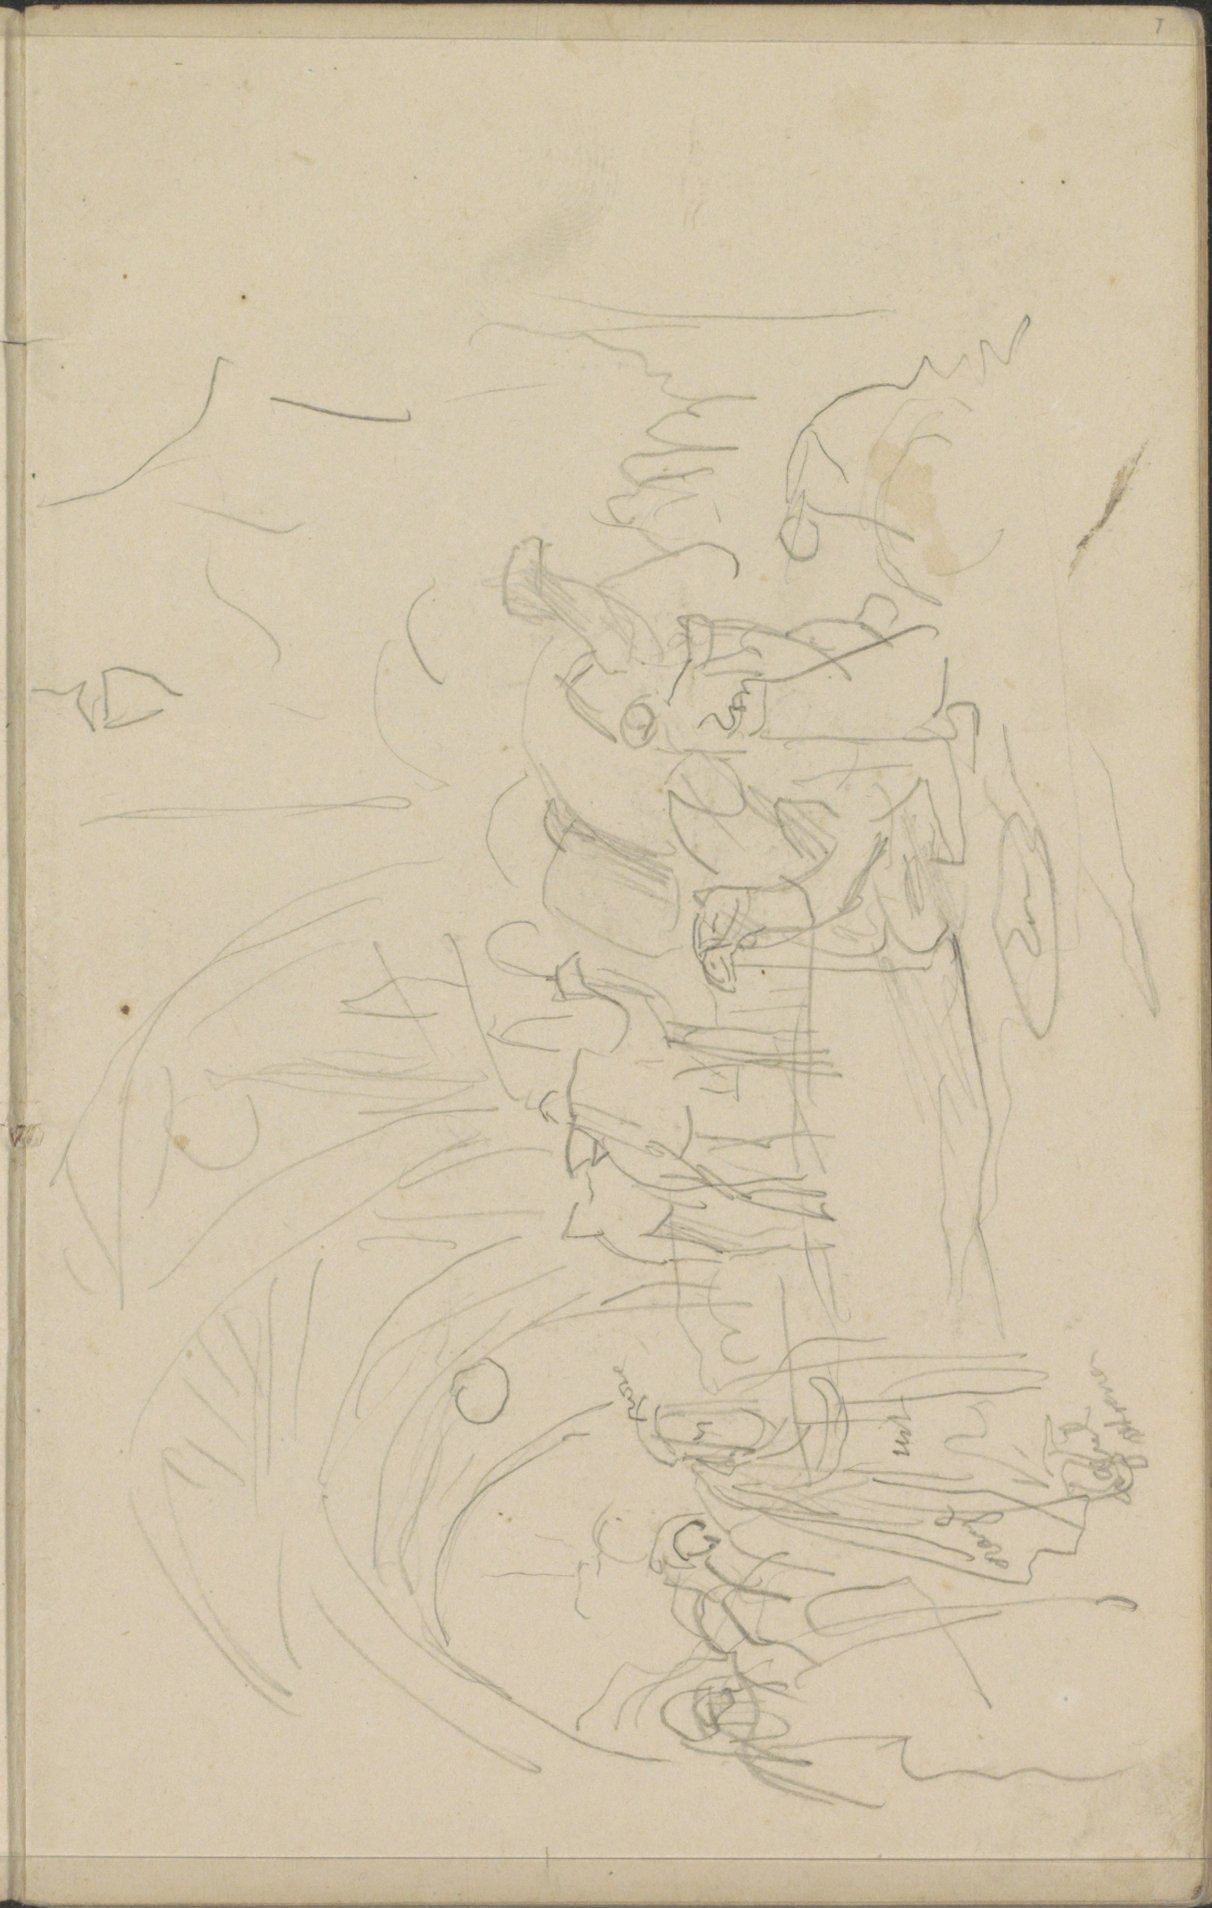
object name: sketchbook leaf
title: Overdekte straat met figuren en bepakte kamelen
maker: marius bauer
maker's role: draughtsman, print maker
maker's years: 1867-1932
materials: paper, pencil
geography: jerusalem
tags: hoofed animals: camel, street (+ city(-scape) with figures, staffage)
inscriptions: kleurnotitie, handgeschreven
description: Pagina 7 uit een schetsboek met 36 bladen.